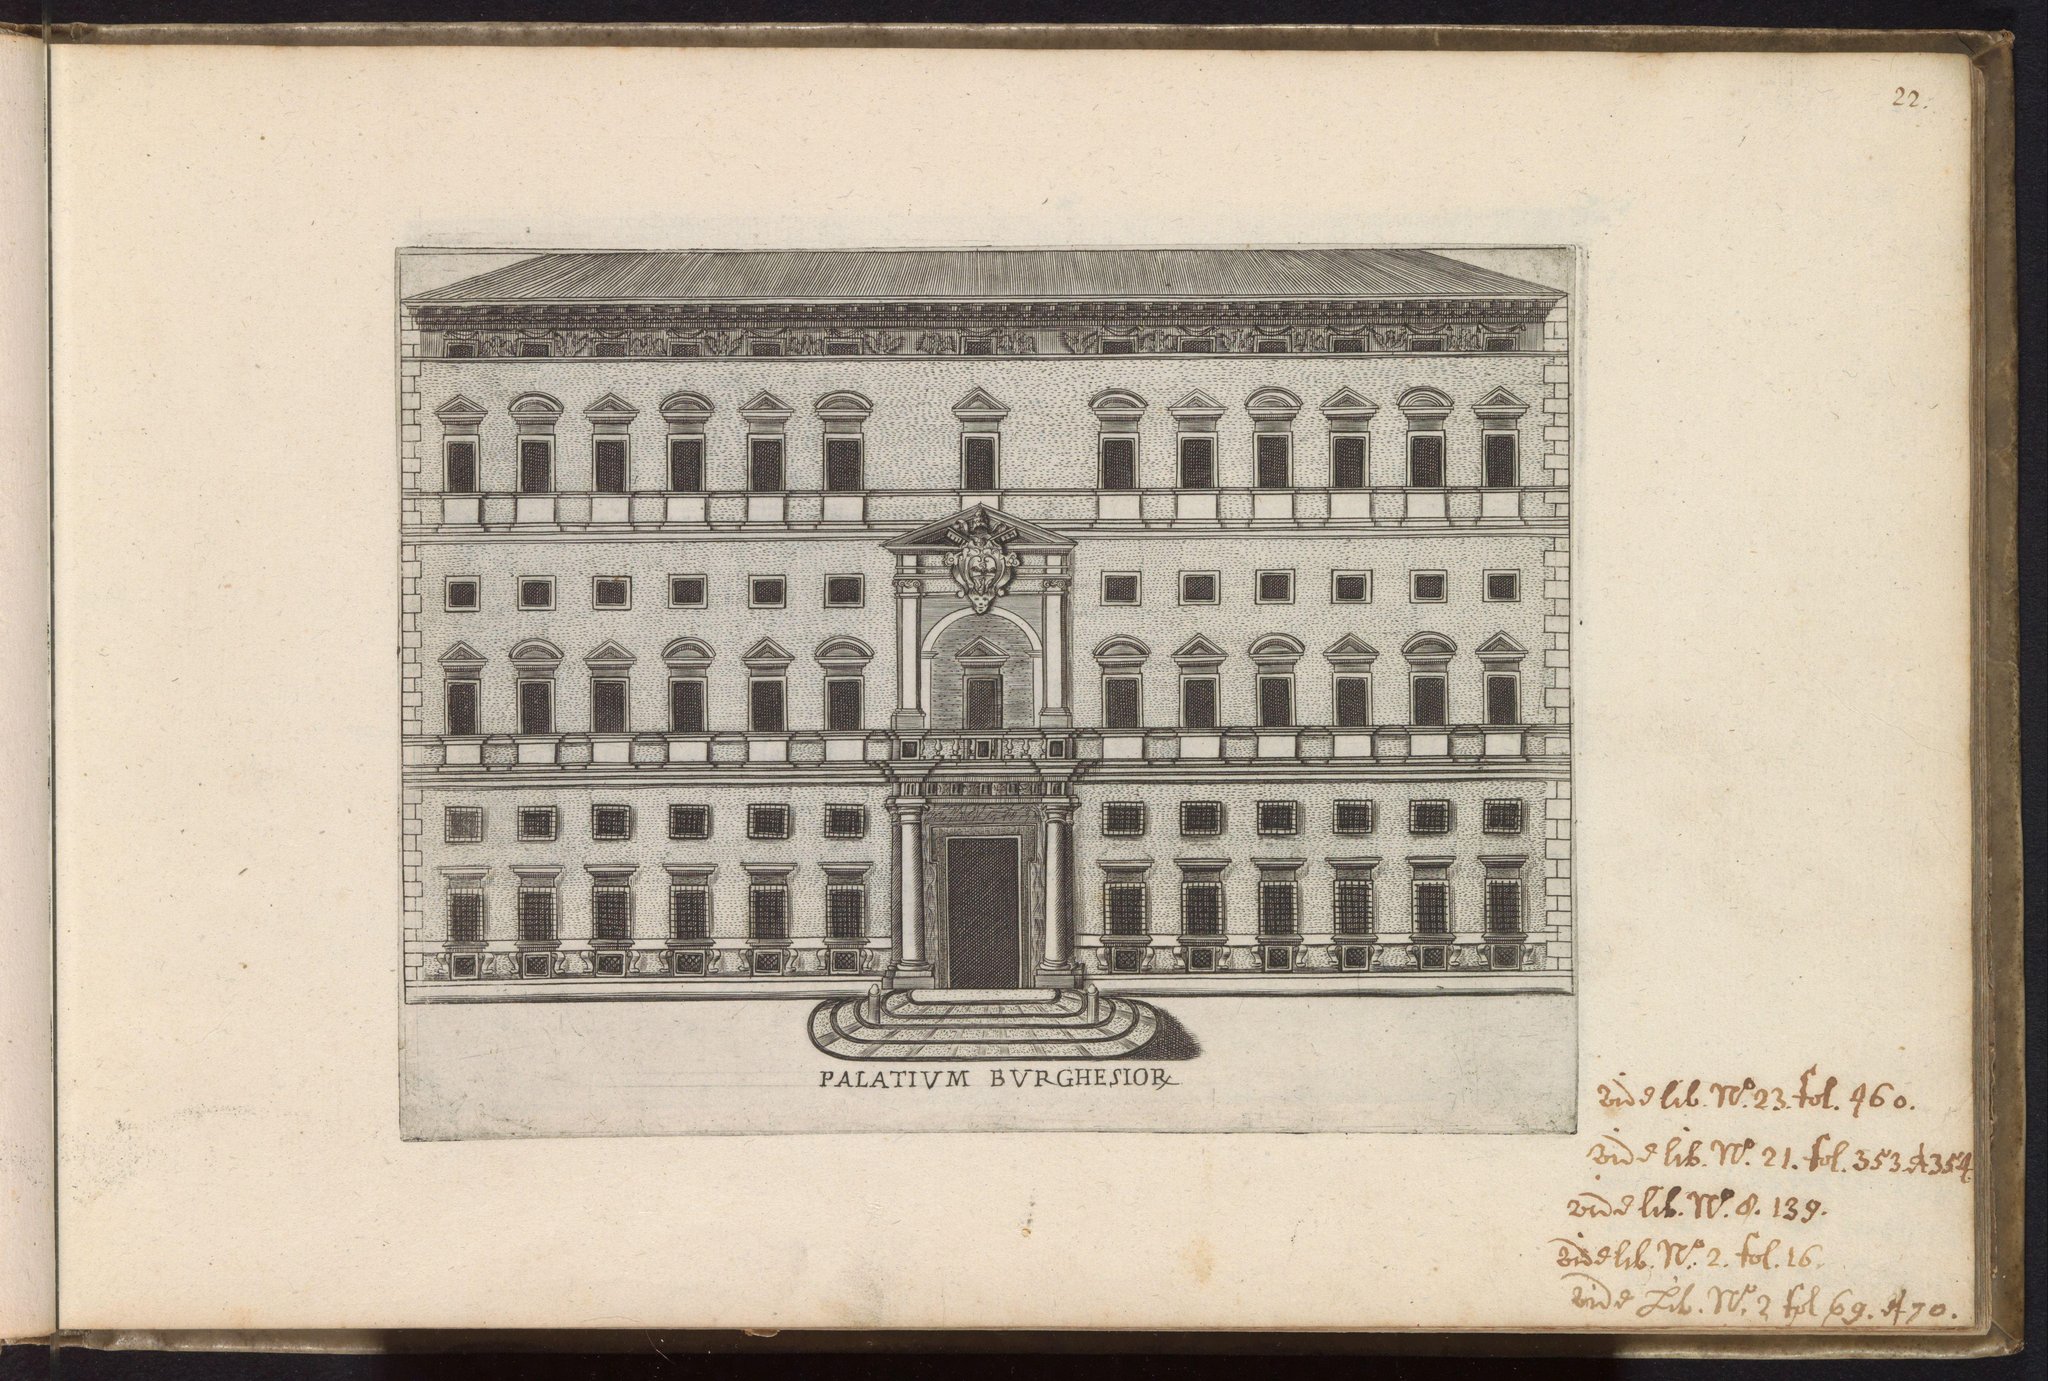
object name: album leaf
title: Palazzi diversi nel'alma cità di Roma, et altre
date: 1638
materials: paper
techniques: etching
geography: rome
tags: hôtel, i.e. small palace in city, façade (of house or building)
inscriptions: inscription: ‘Ende lib. No. 23. fol. 460./ Ende lib. No. 21. fol. 353 et 354...’, number: ‘22’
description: Prent maakt deel uit van een reeks prenten (+ titelprent) van beroemde gebouwen in Rome en elders.